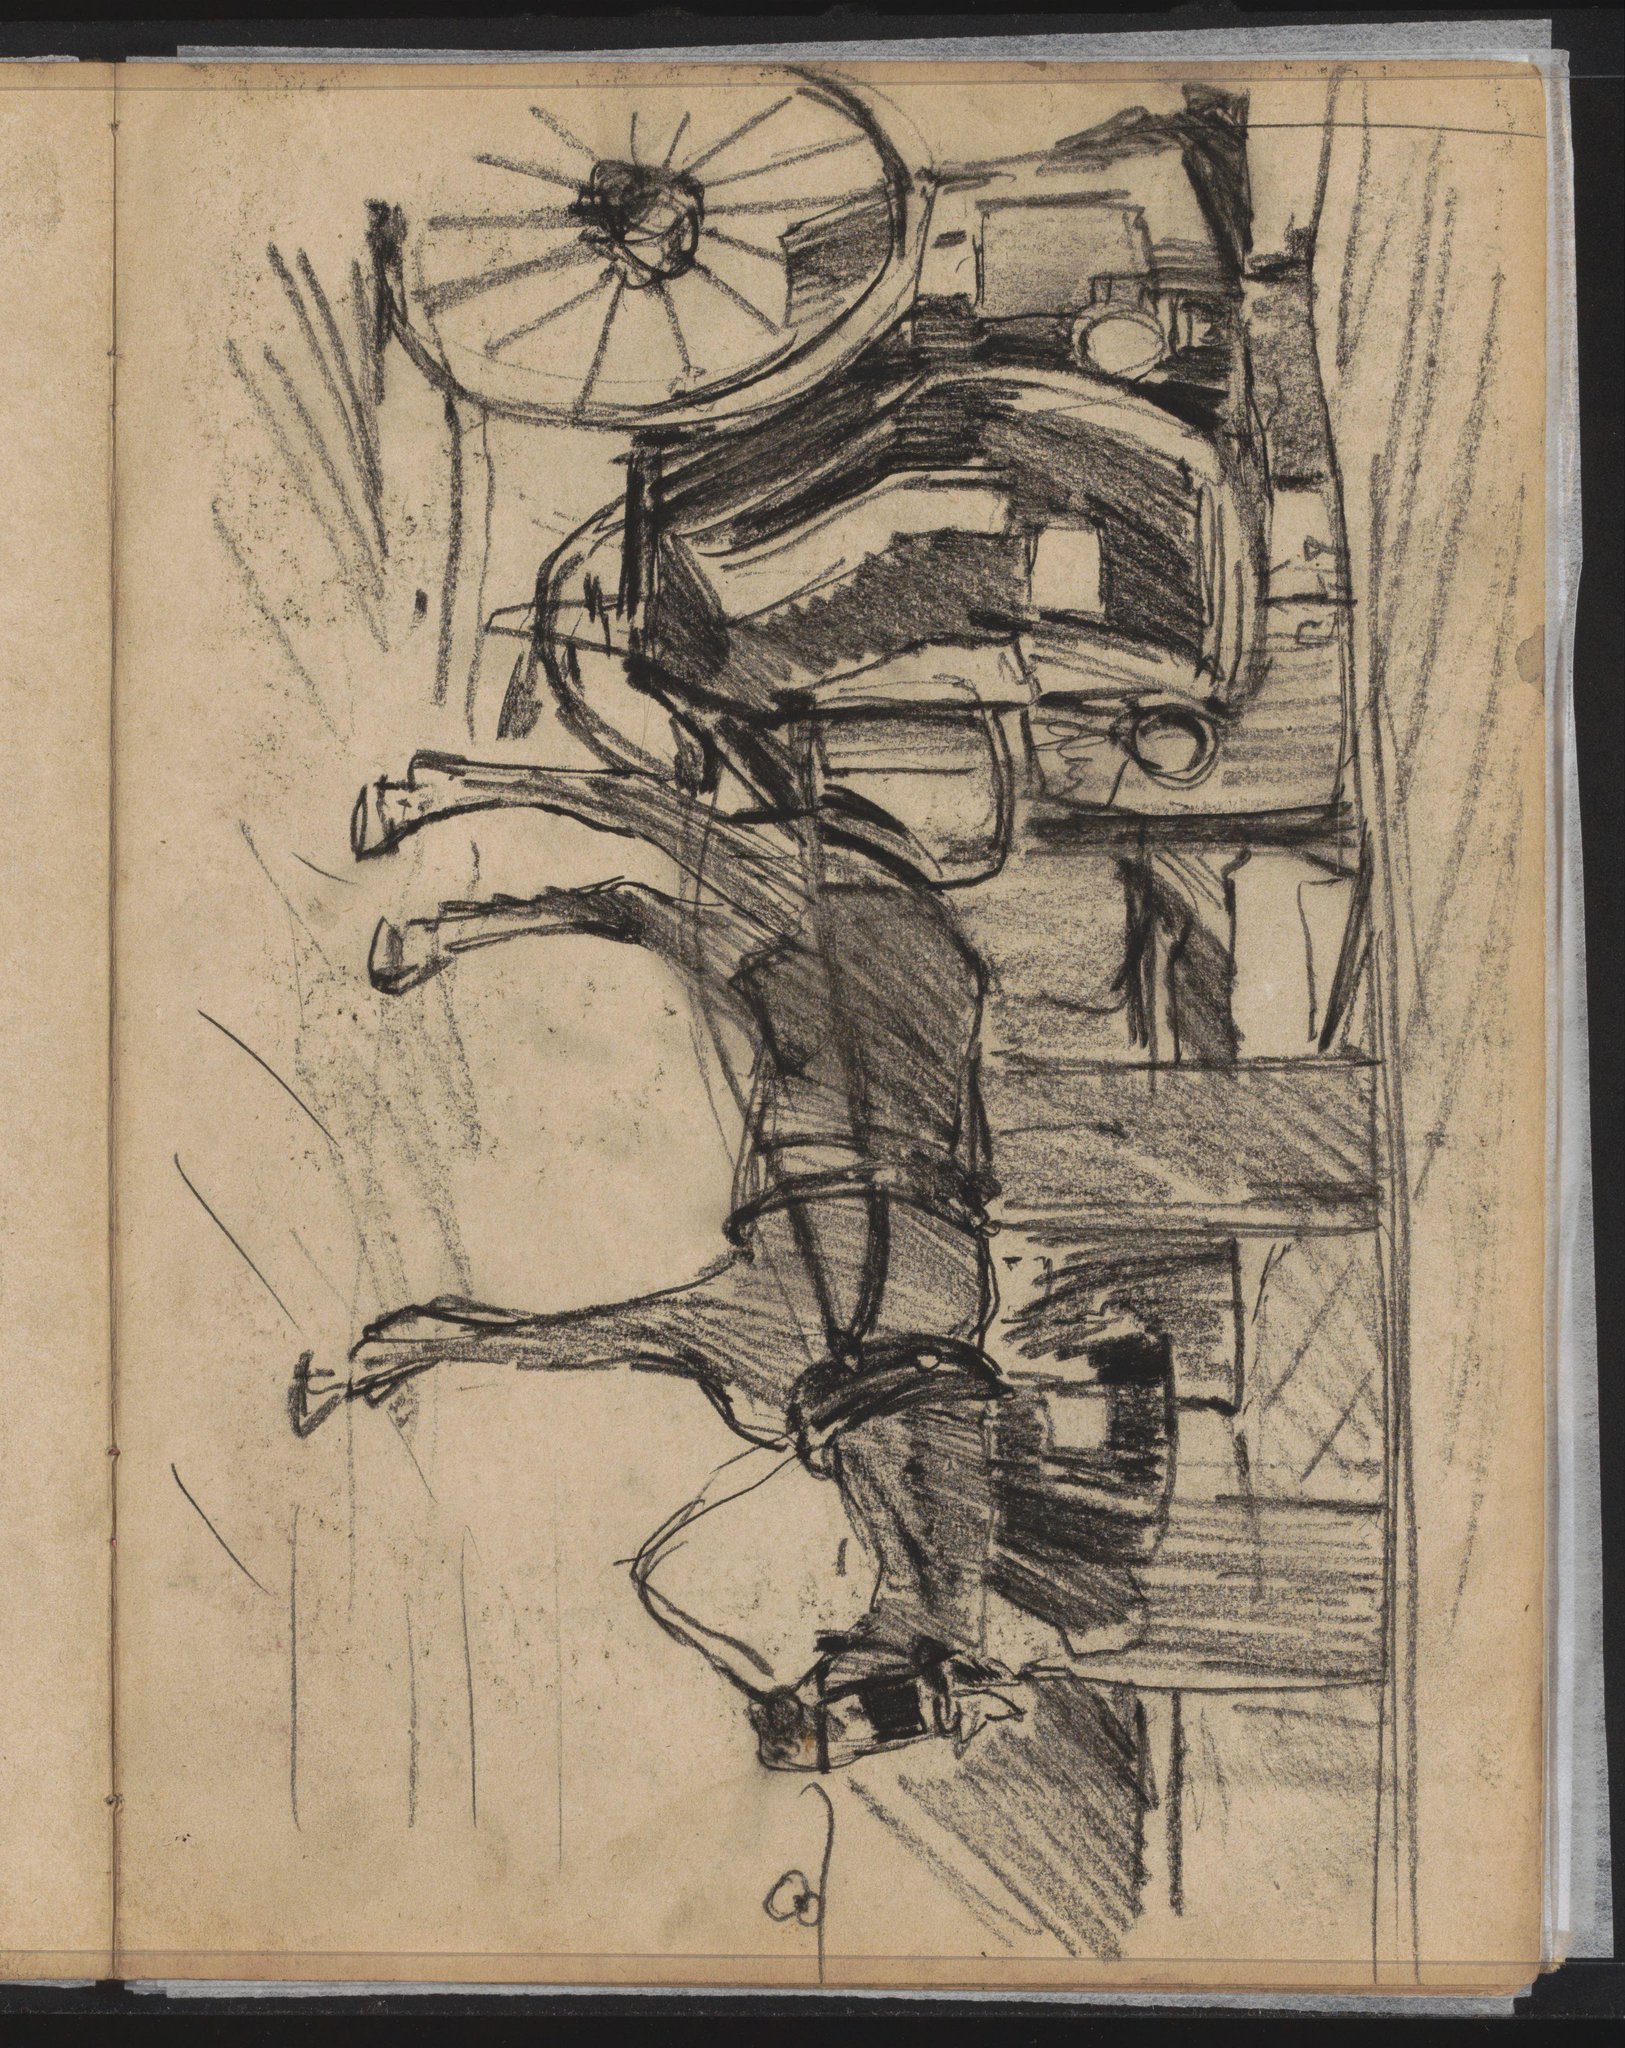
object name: sketchbook leaf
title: Rijtuigen onder Charing Cross Bridge te Londen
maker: willem witsen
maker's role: draughtsman, painter, print maker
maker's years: 1860-1923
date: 1888-1890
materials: chalk, paper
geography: london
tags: horse, bridge in city across river, canal, etc., two-wheeled vehicle drawn by one animal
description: Voorstudie voor de ets 'Standplaats voor rijtuigen onder Charing Cross Bridge, Londen', 1890.